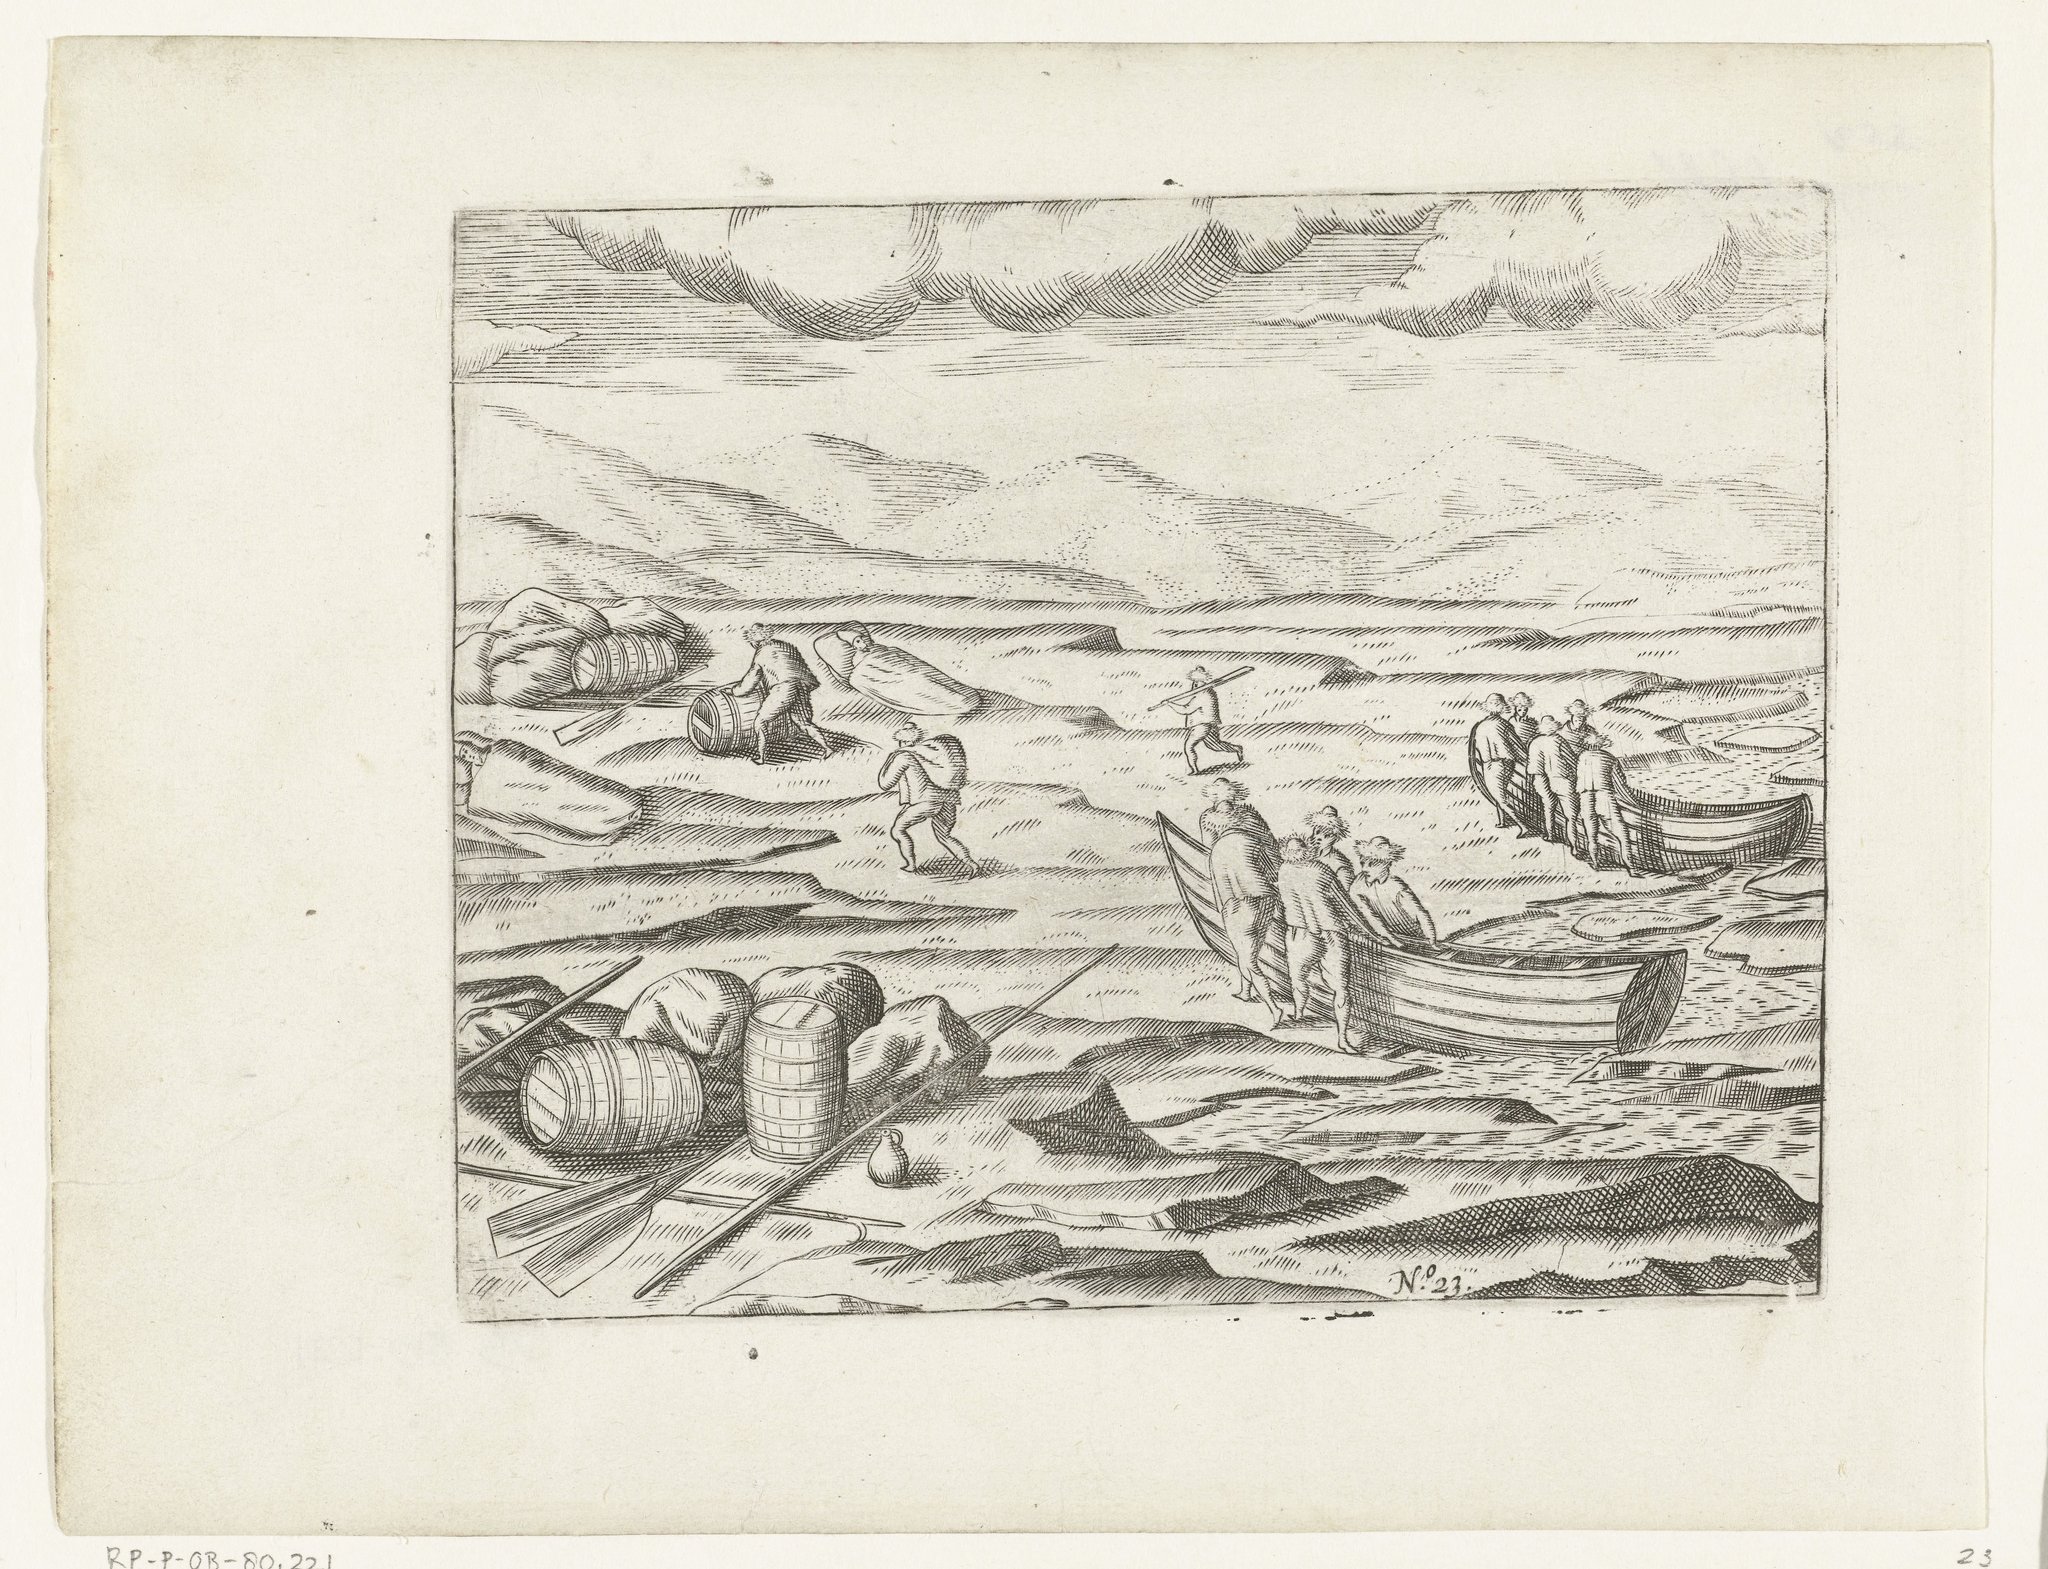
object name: print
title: De sloepen worden uit het water gehaald, 1597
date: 1615-1617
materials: paper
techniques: engraving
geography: northern netherlands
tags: willem barendsz., jacob van heemskerck, landscapes in polar regions, exploration, expedition, voyage of discovery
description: Gebruikt als illustratie eerst in: G. de Veer, De waerachtige beschrijvinge vande drie seylagien, drie jaren achter mal-kanderen deur de Hollandtsche ende Zeelandtsche Schepen, by noorden Noorweghen, Moscovien ende tartarien nae de Coninckrijcken van Catthay ende China ghedaene, [Michiel Colijn, Amsterdam 1617]. Later gebruikt in: Kort verhael van d'eerste Schipvaerd der Hollandsche ende Zeeusche Schepen by noorden Noorwegen, Moscovien ende Tartarien om, nae de Coningrijcken van Cathay ende China, getogen uyt het Journael van Gerrit de Veer. Opgenomen in: I. Commelin, Begin ende voortgangh, van de Vereenighde Nederlantsche Geoctroyeerde Oost-Indische Compagnie, J. Janssonius, Amsterdam 1646. Genummerd: No. 23.